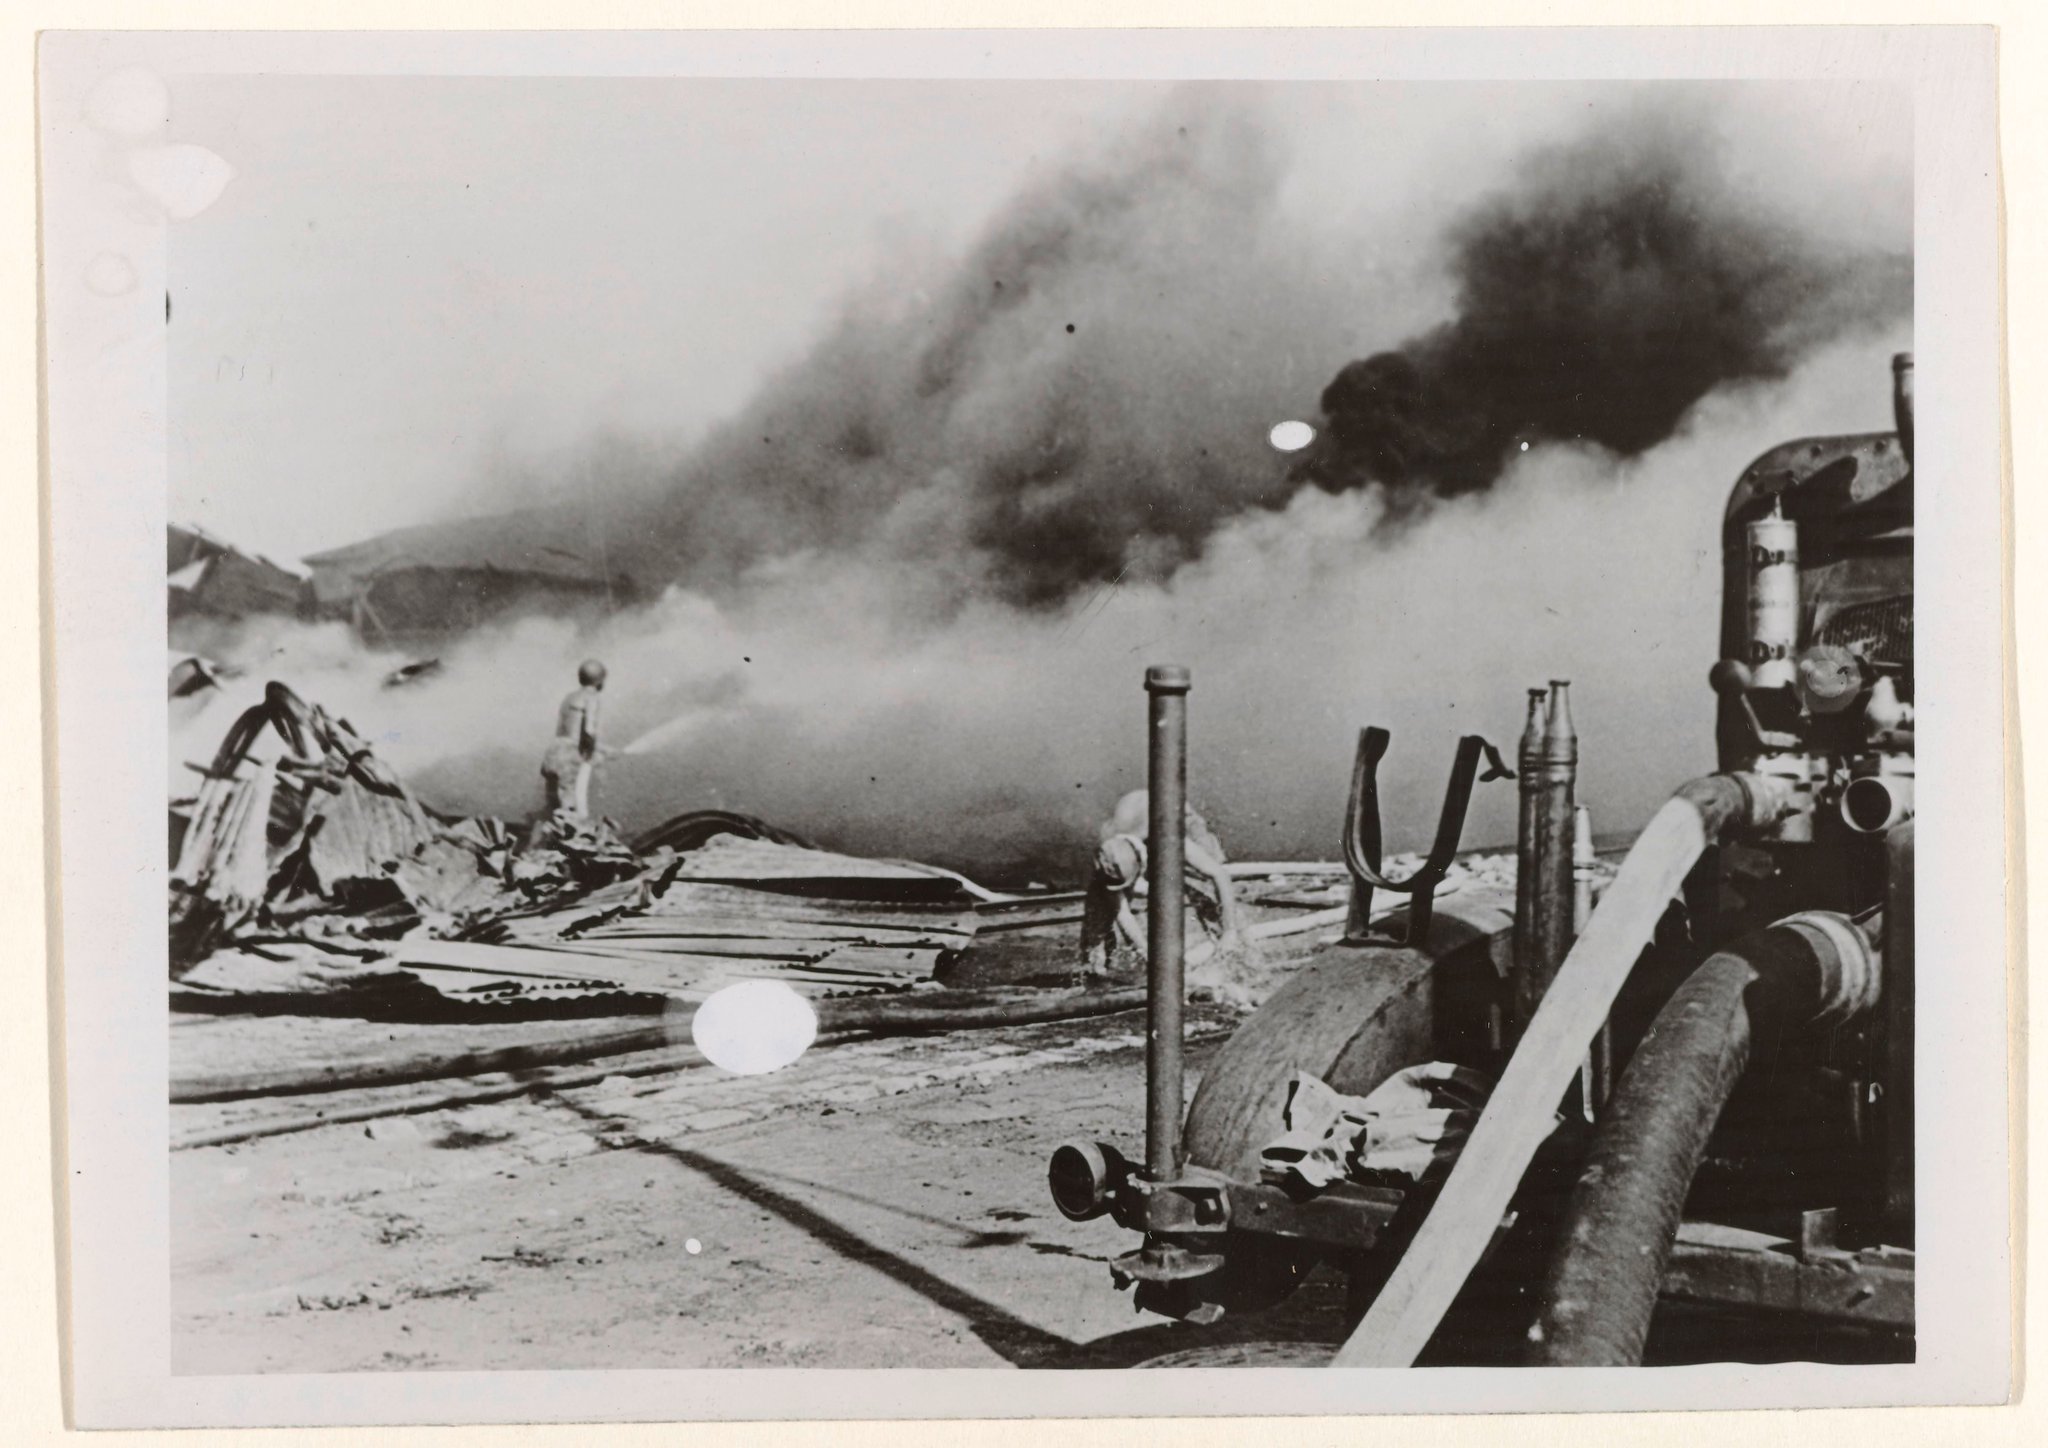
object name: photograph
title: Brand in Probolinggo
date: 1947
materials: photographic support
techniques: photography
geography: java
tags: guerilla warfare, revolution, revolt, java, dutch east indies, the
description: Mariniers zijn bezig met het blussen van een brand in de pakhuizen in Probolinggo. Rechts een bluswagen, 31 juli 1947.